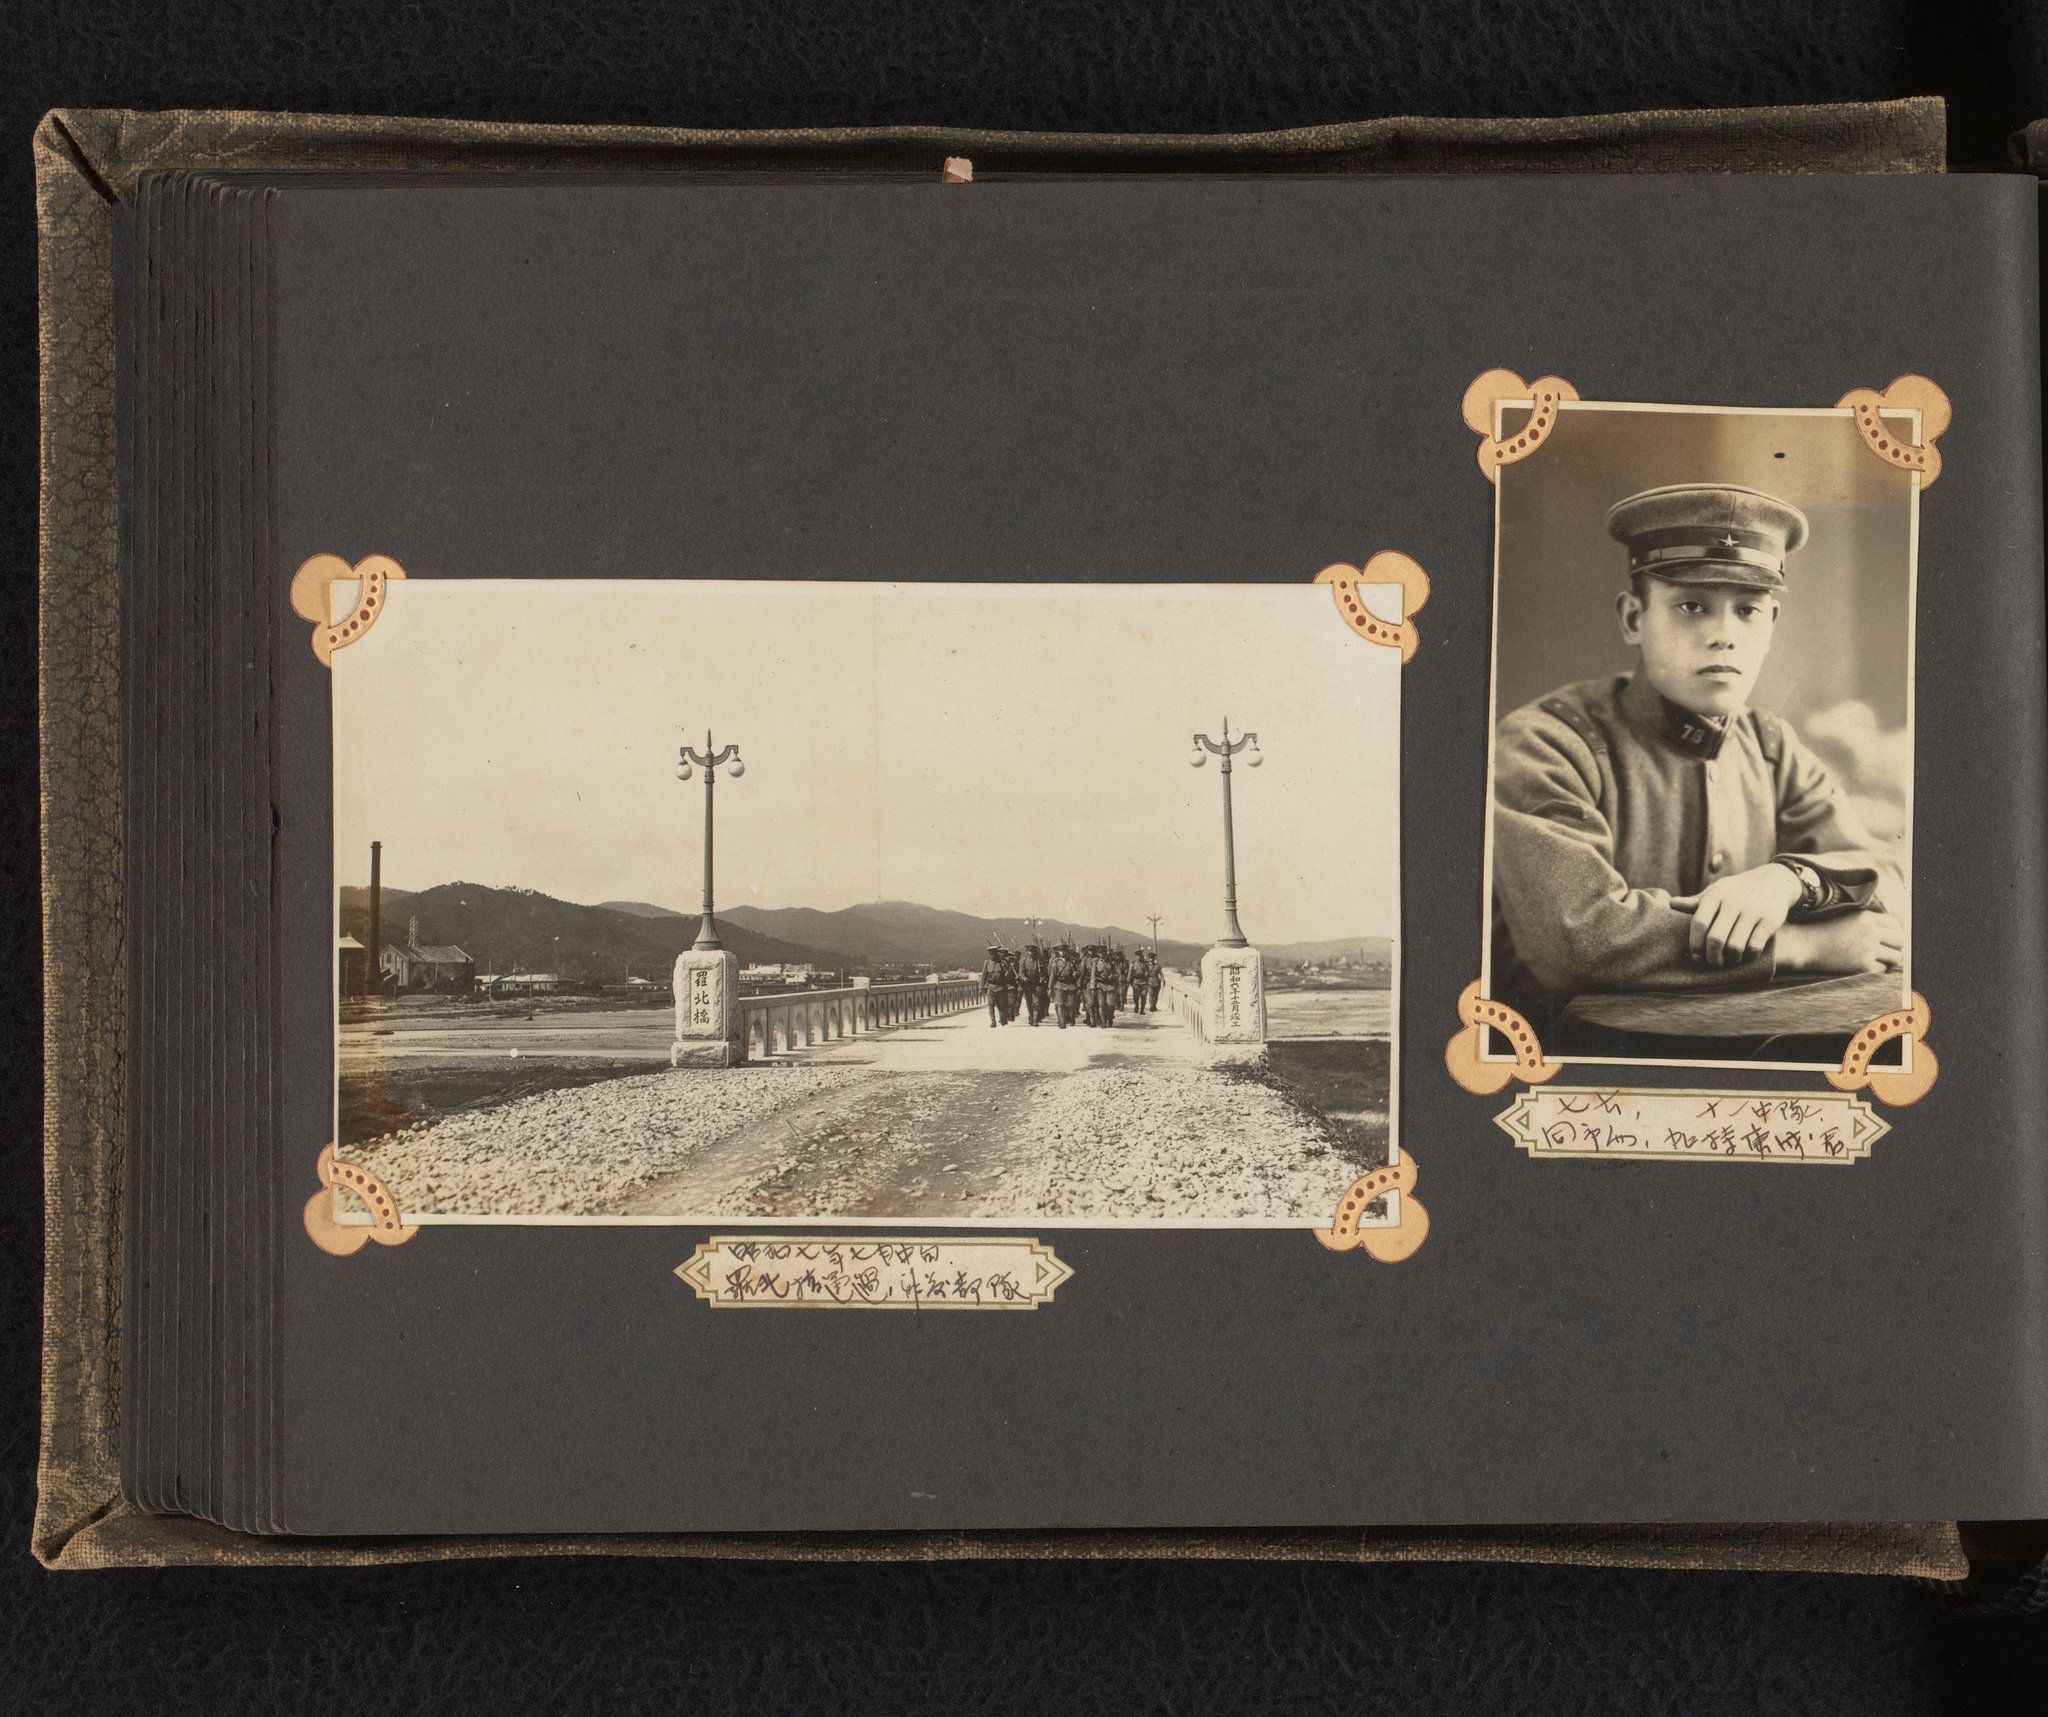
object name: album leaf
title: Japanse soldaten op een brug tijdens patrouille, en een portret van een onbekende soldaat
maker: Anonymous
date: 1930-1940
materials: paper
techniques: gelatin silver print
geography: korea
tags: anonymous historical person portrayed, the soldier; the soldier's life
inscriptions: inscription: ‘[...]’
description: Deze foto's zijn onderdeel van een album.